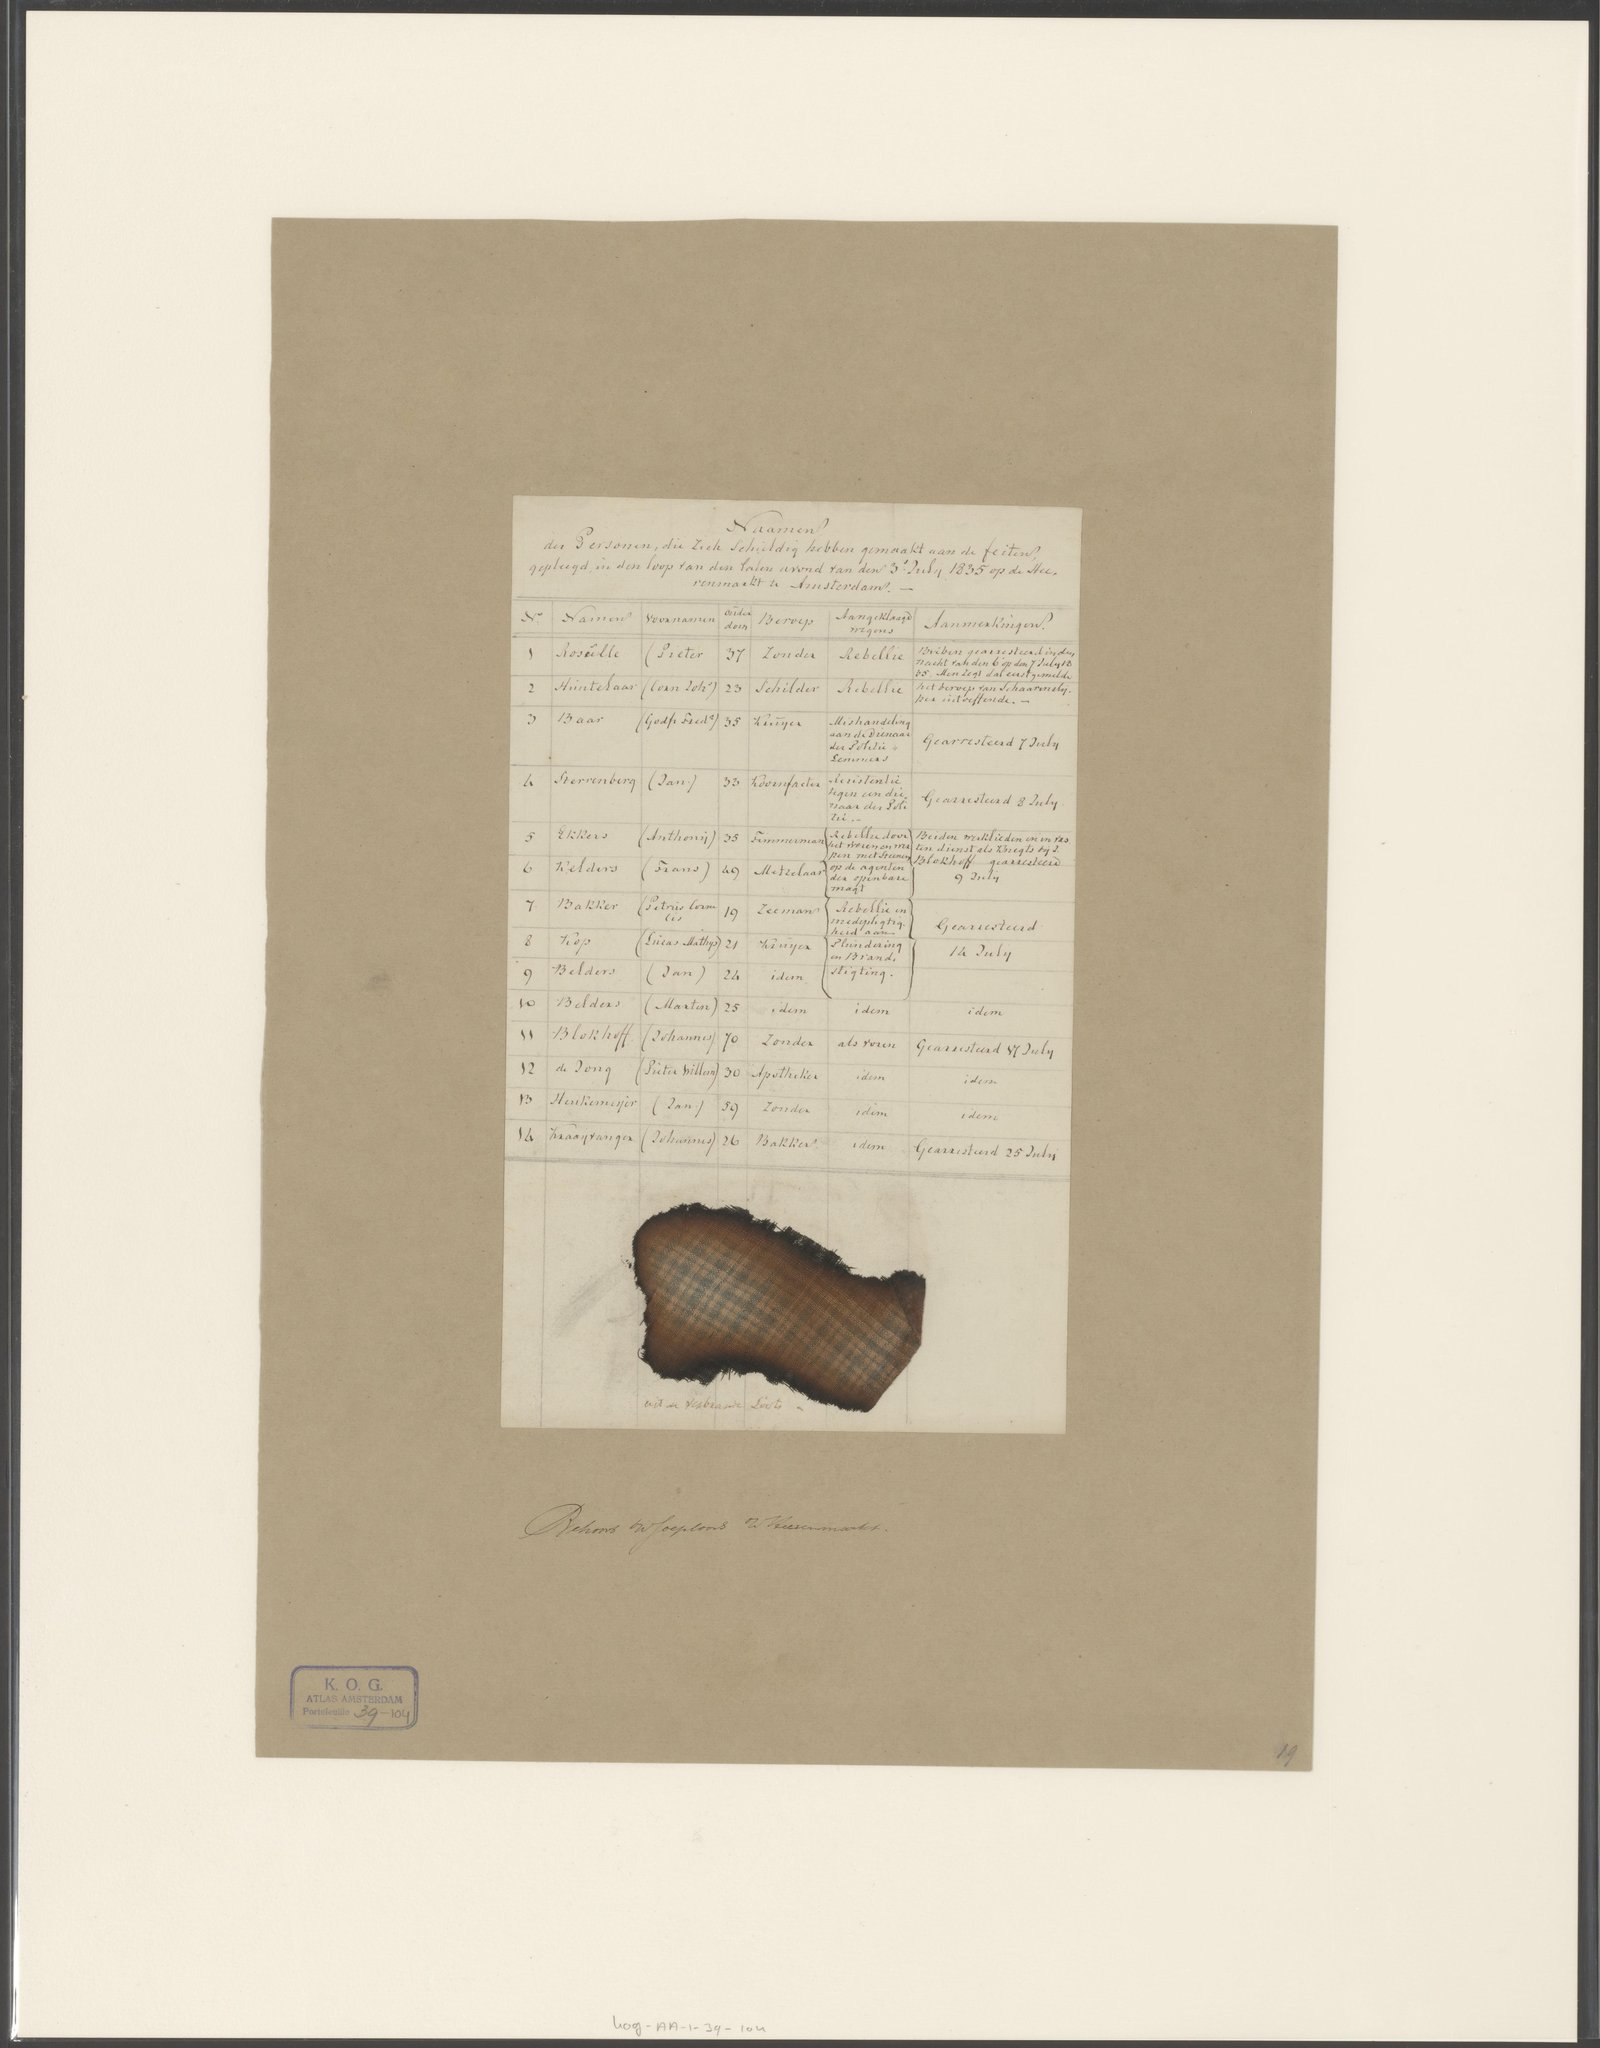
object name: frame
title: Naamen der Personen die zich schuldig hebben gemaakt aan de feiten, gepleegd in den loop van den laten avond van den 3e Julij 1835 op de Heerenmarkt te Amsterdam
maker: Anonymous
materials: ink, paper, textile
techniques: pen, weave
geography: netherlands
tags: arrest (of criminal), textile fabric, cloth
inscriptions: collector's mark: Lugt 1641b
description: Onderwerpsrubriek binnen de Atlas Amsterdam: Armwezen en liefdadige instellingen: III. Verschillende gestichten en instellingen / Hofjes: Maatschappij van Weldadigheid - Soeploods op Heerengracht.